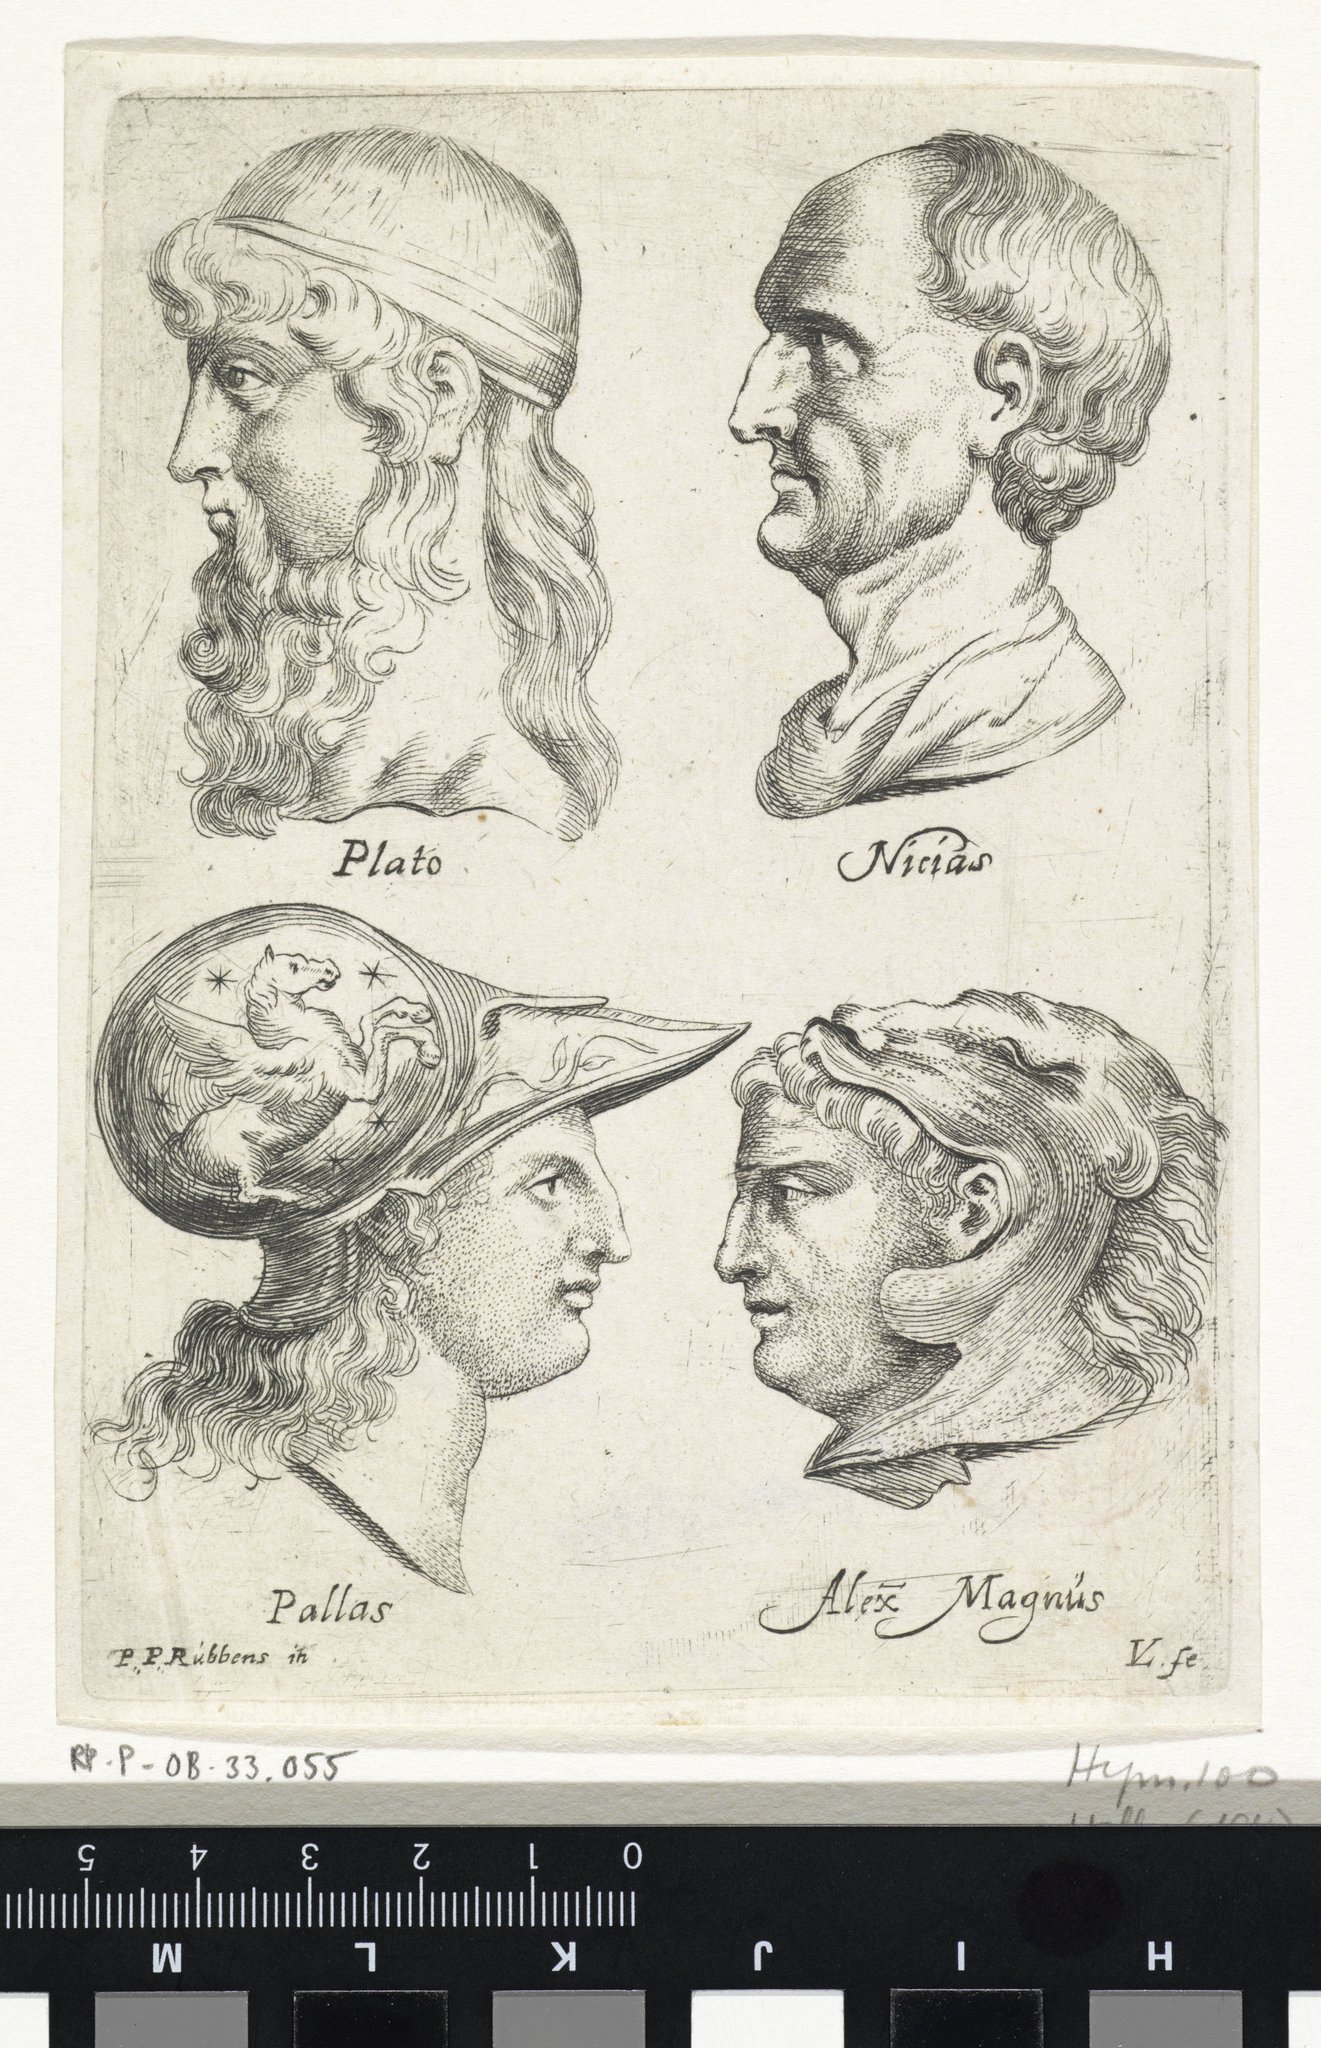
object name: print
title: Varie Figueri de Agati Antique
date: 1635-1640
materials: paper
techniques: engraving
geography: antwerp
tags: politician, male persons from classical history (plato), (story of) minerva (pallas, athena), (story of) alexander the great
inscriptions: collector's mark: Lugt 240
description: Vier antieke bustes in profiel: linksboven Plato, rechtsboven Nicias, linksonder Minerva en rechtsonder Alexander de Grote. Prent uit de serie 'Varie Figueri de Agati Antique' naar Peter Paul Rubens, van in totaal negen prenten waarvan vermoedelijk vijf door Lucas Vorsterman I en vier door Paulus Pontius.